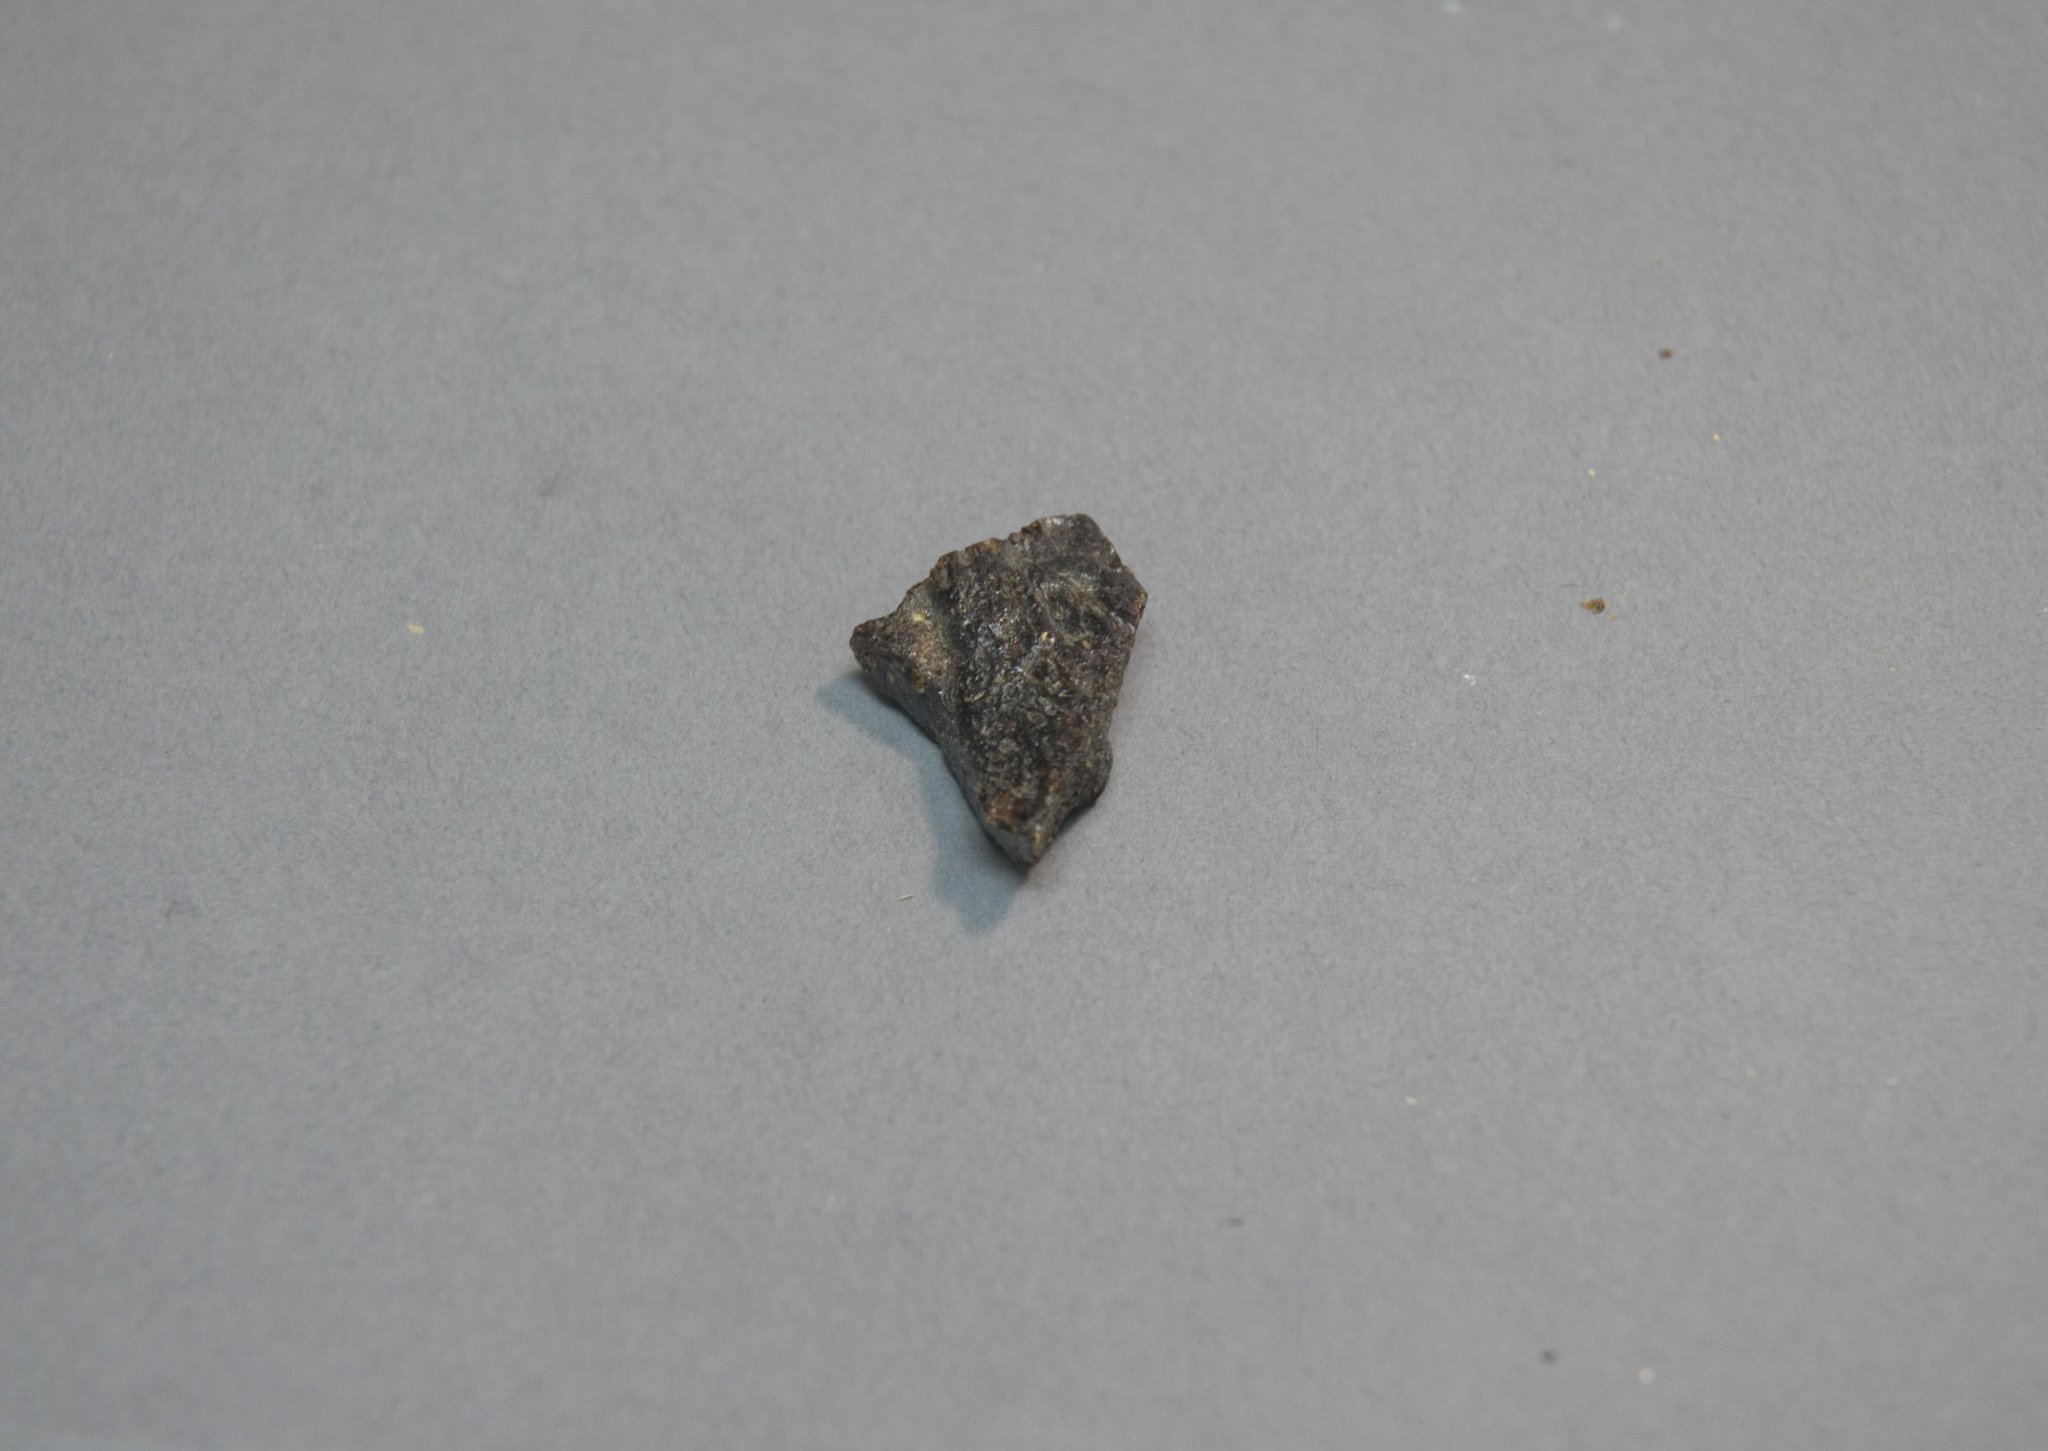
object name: jade carving material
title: Shellac Specimen for Jade Carving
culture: chinese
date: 1901-2000